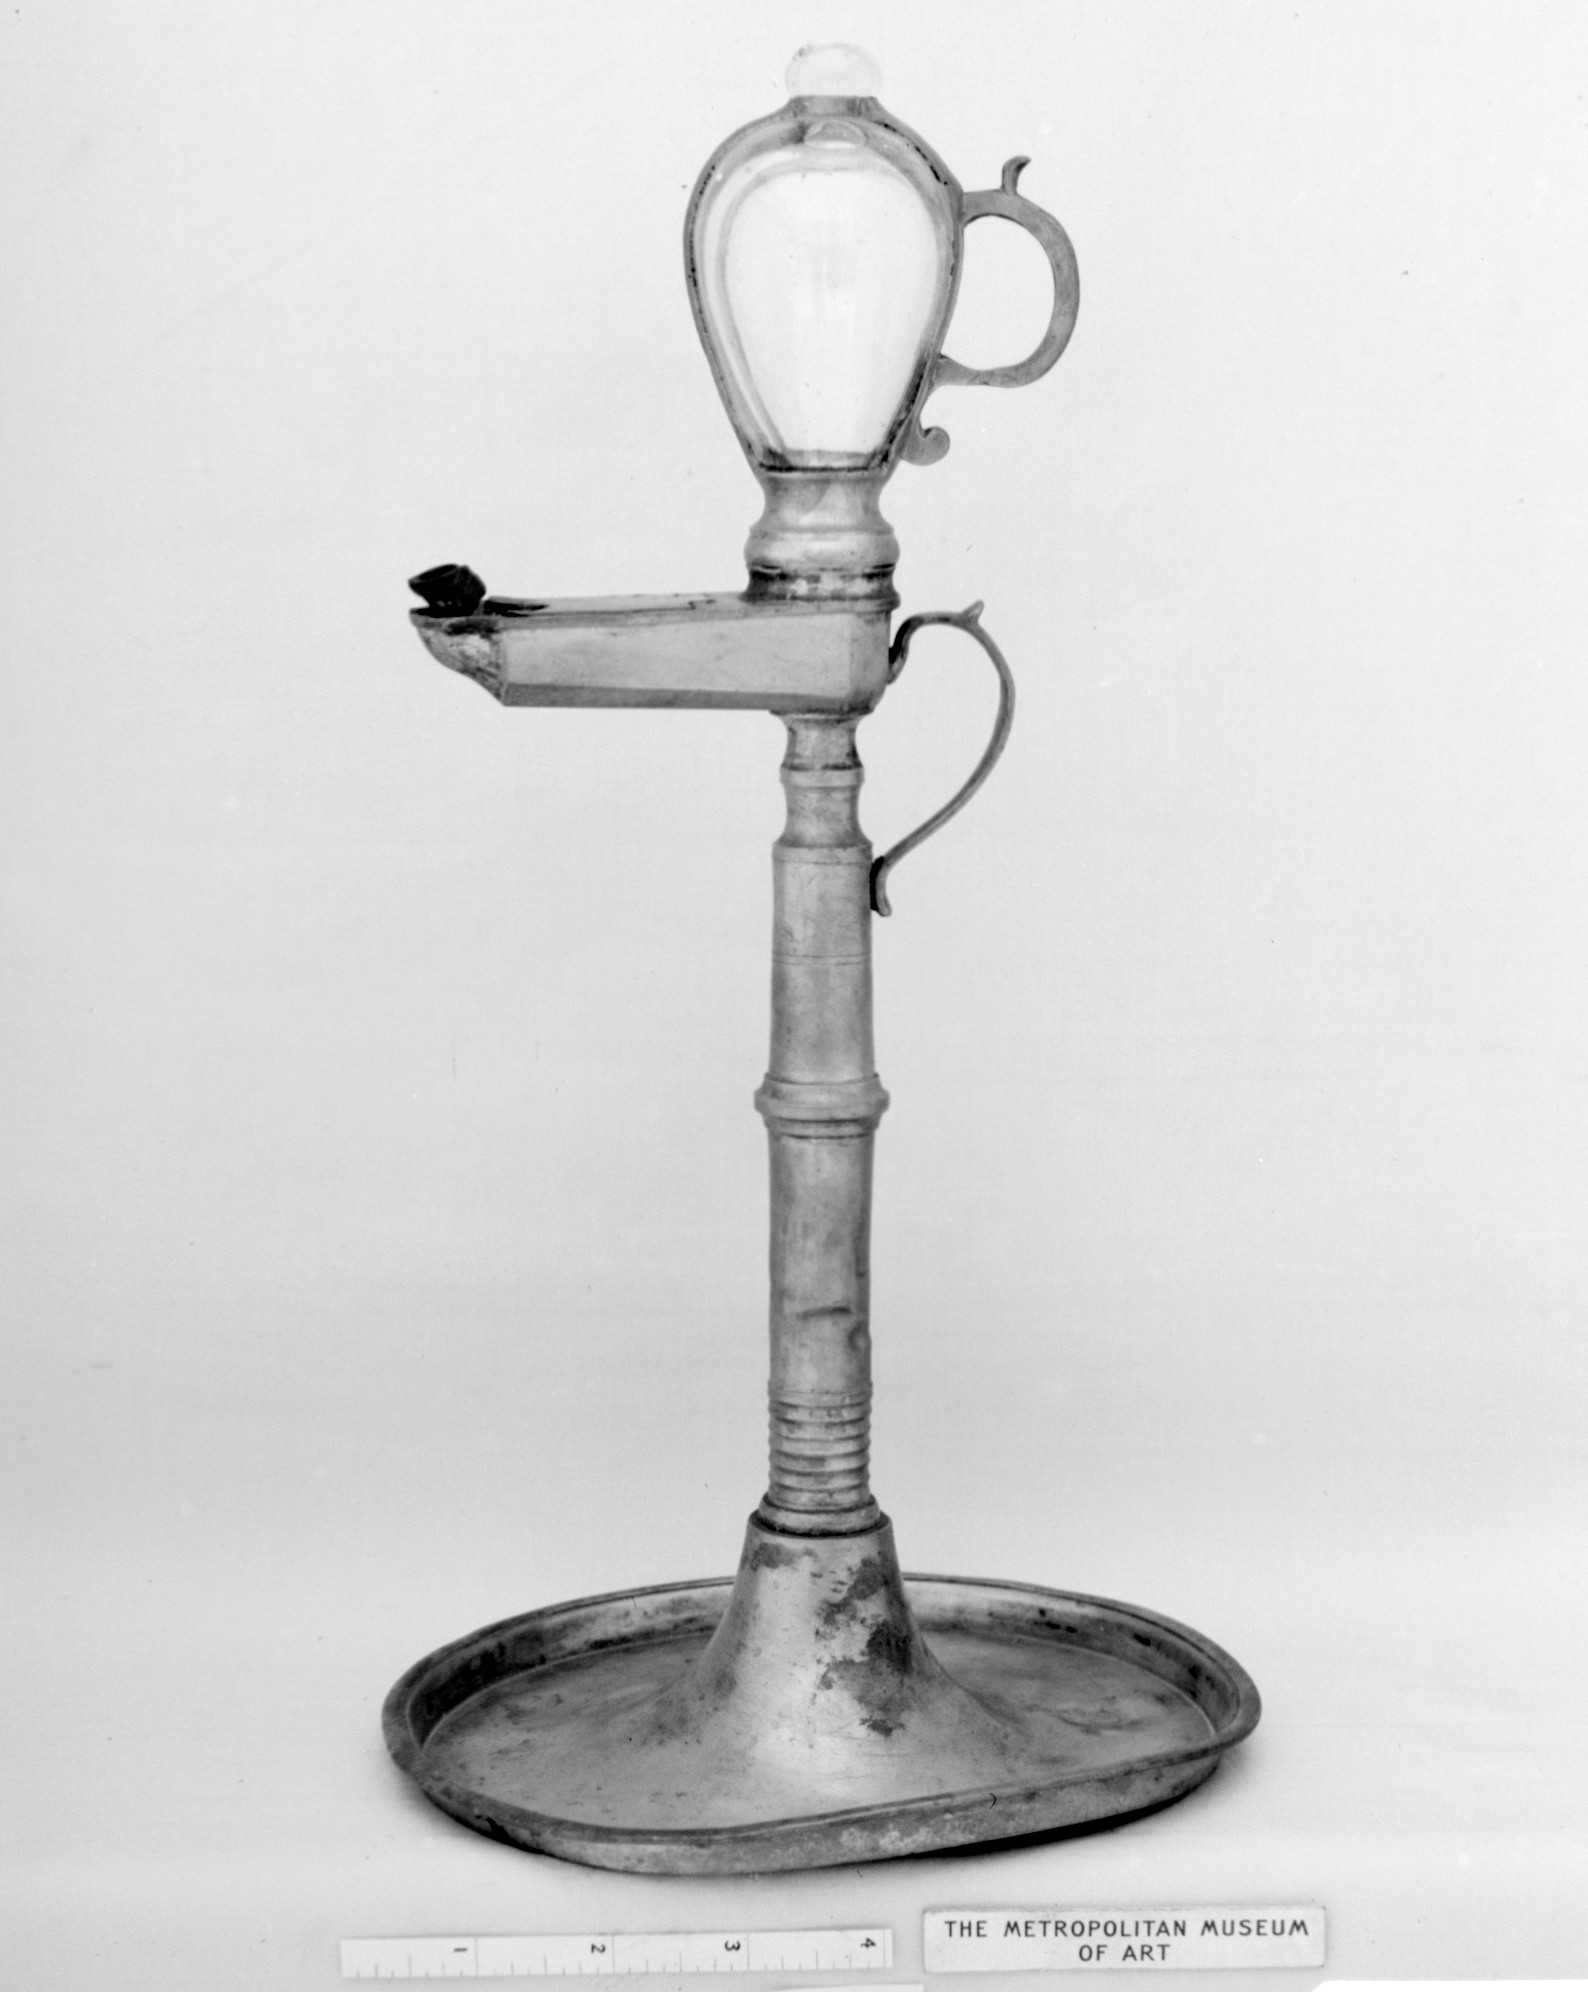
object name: time keeping lamp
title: Time-keeping lamp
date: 1601-1700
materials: pewter